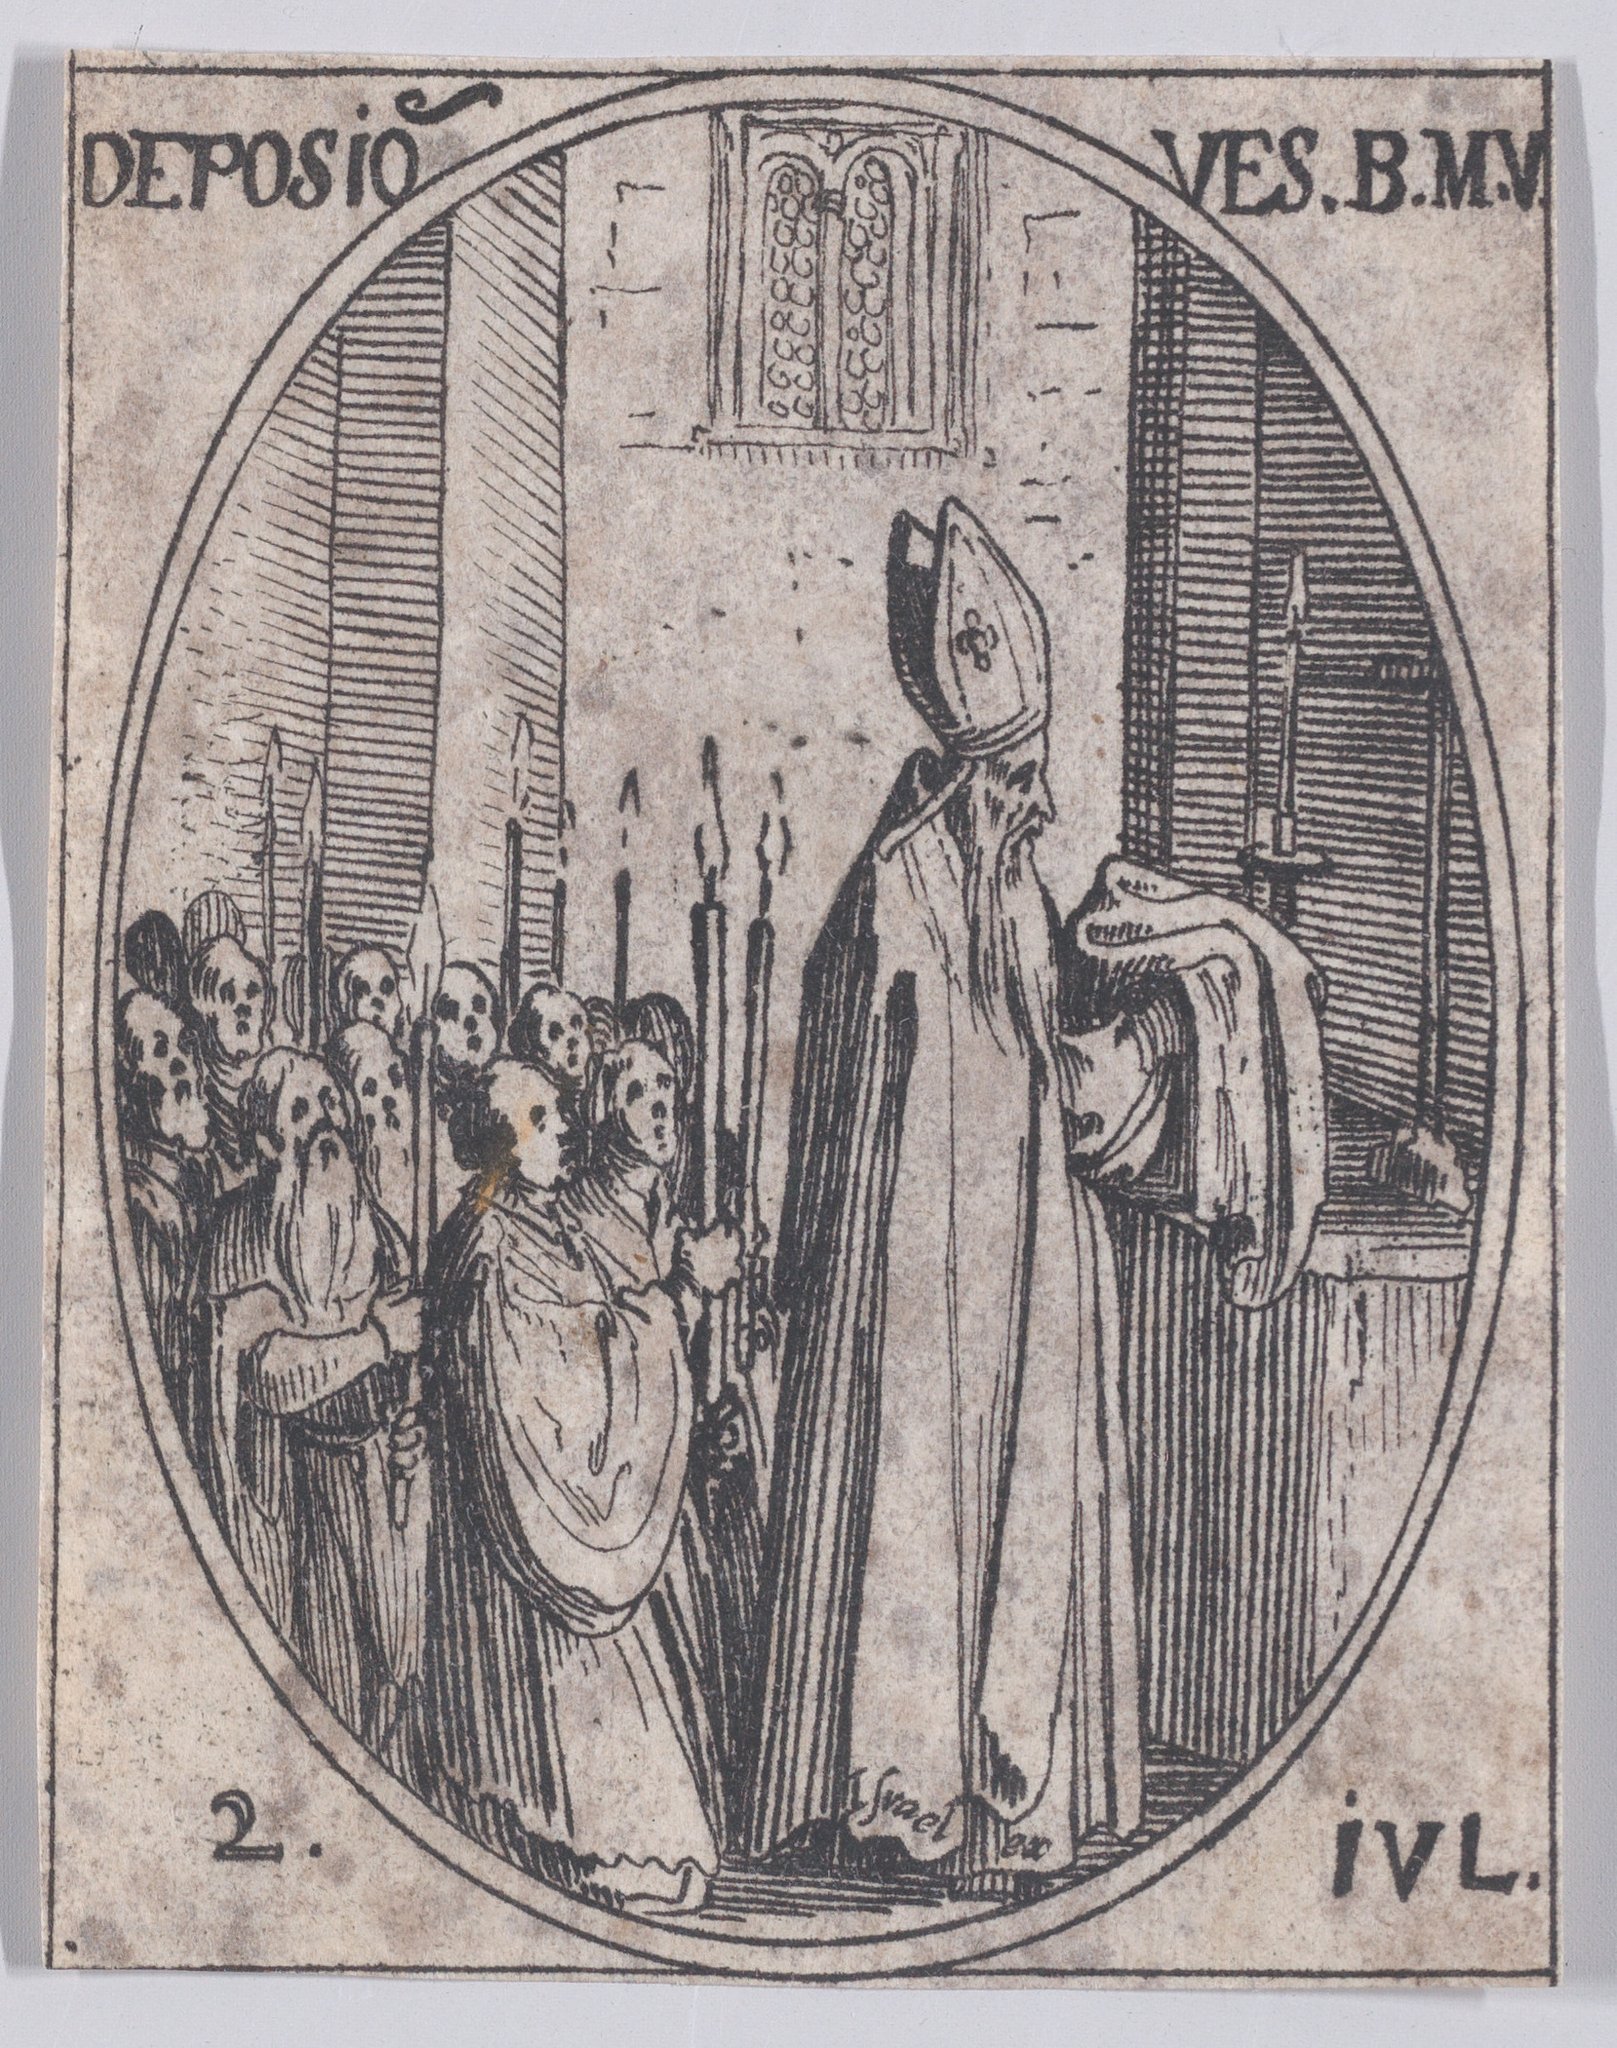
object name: print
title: La Déposition des Vêtements de la Sainte Vierge (The Deposition of the Virgin's Clothes), July 2nd, from "Les Images De Tous Les Saincts et Saintes de L'Année" (Images of All of the Saints and Religious Events of the Year)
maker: jacques callot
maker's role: artist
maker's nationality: french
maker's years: 1592-1635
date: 1636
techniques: etching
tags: men,saints